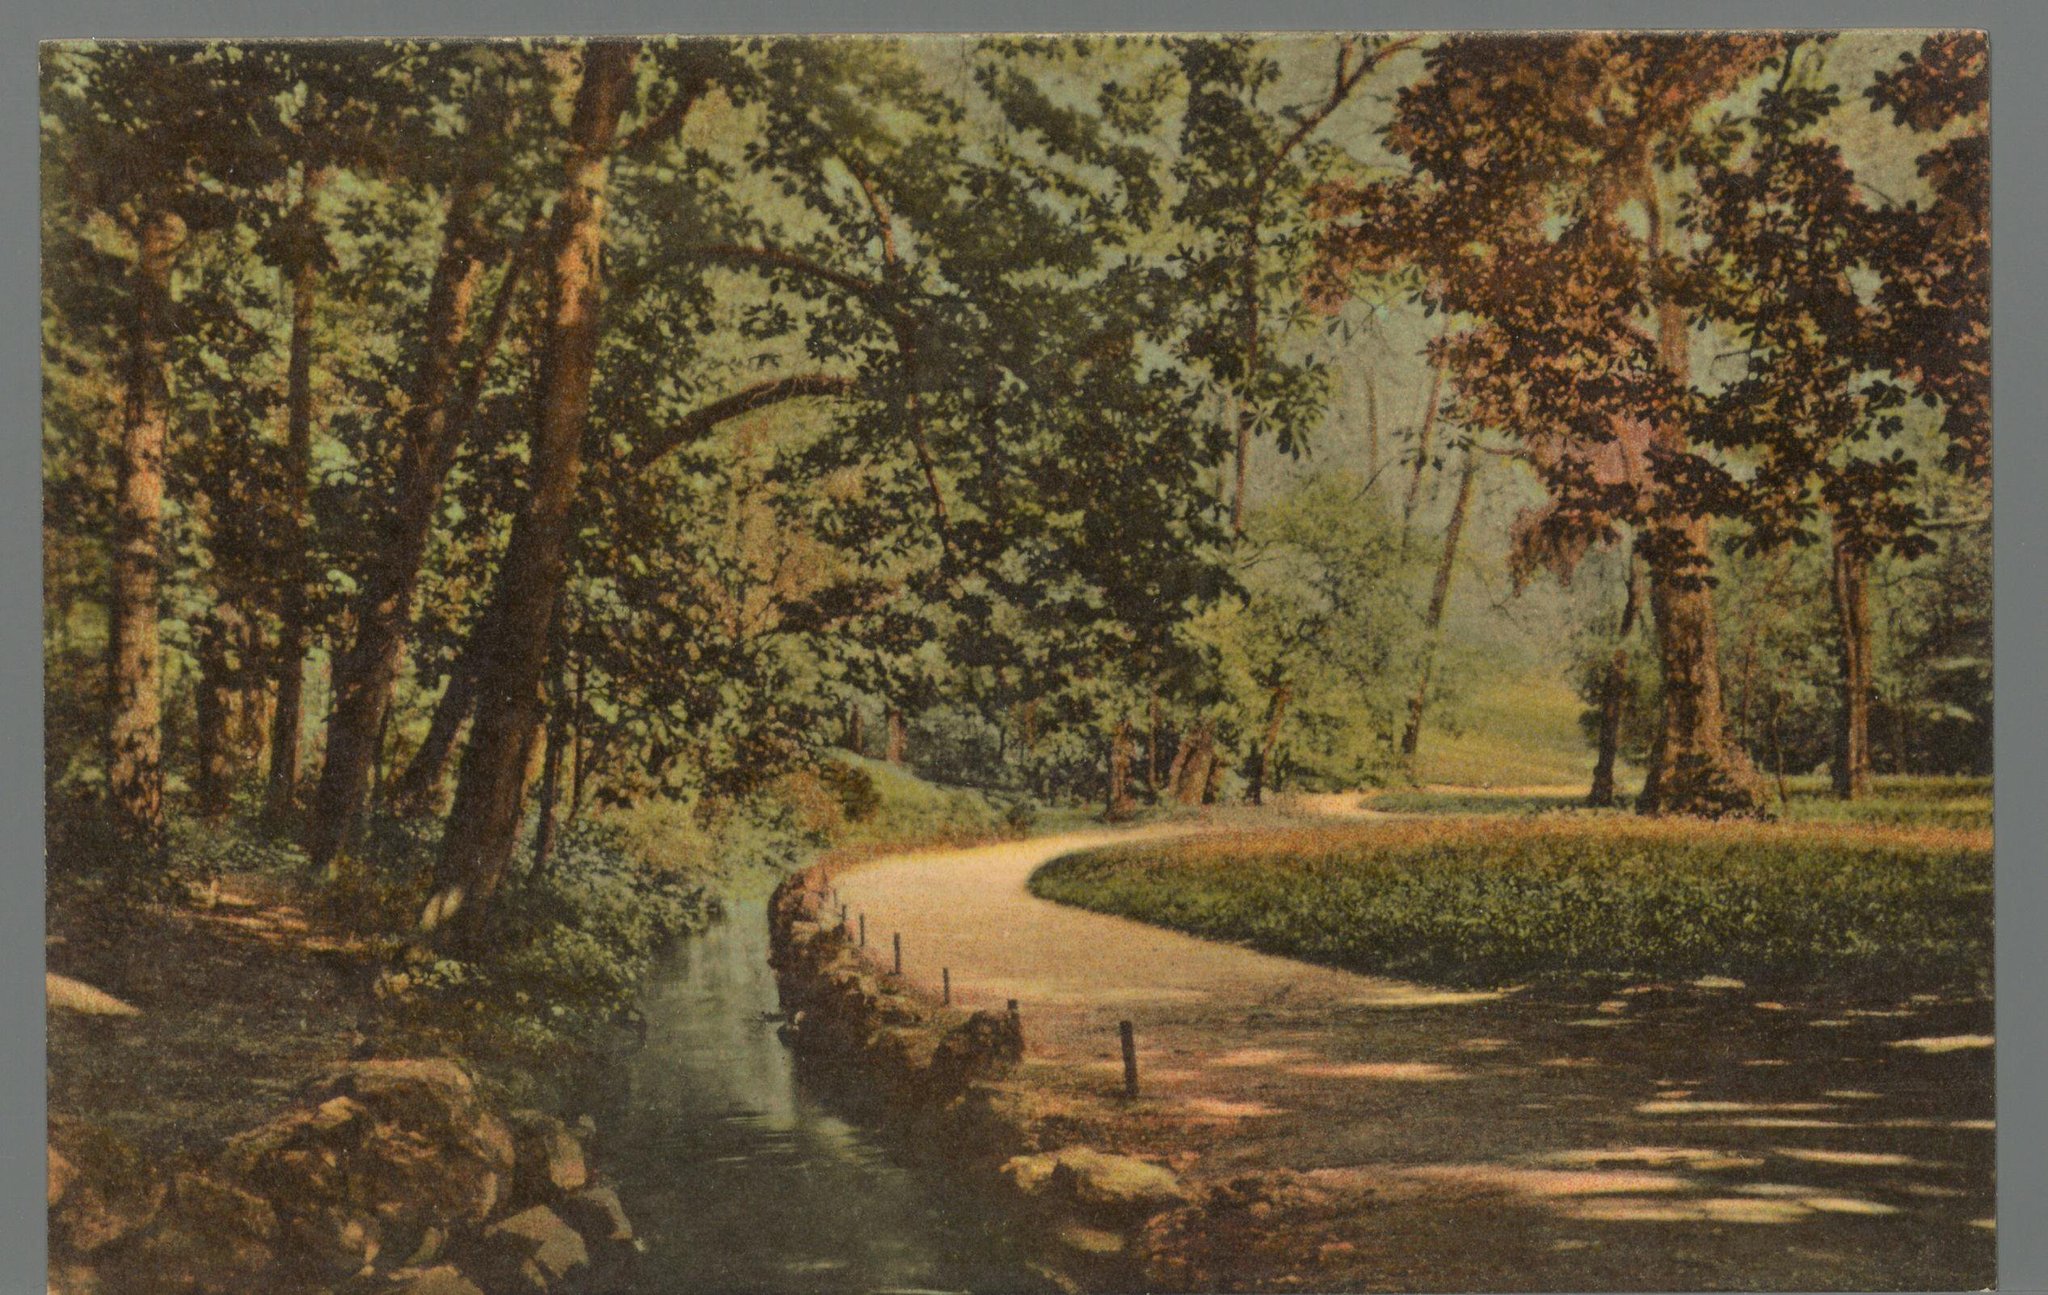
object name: photomechanical print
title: Weimar. Im Park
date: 1905-1930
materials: cardboard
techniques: photograph, lithograph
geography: hamburg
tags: park